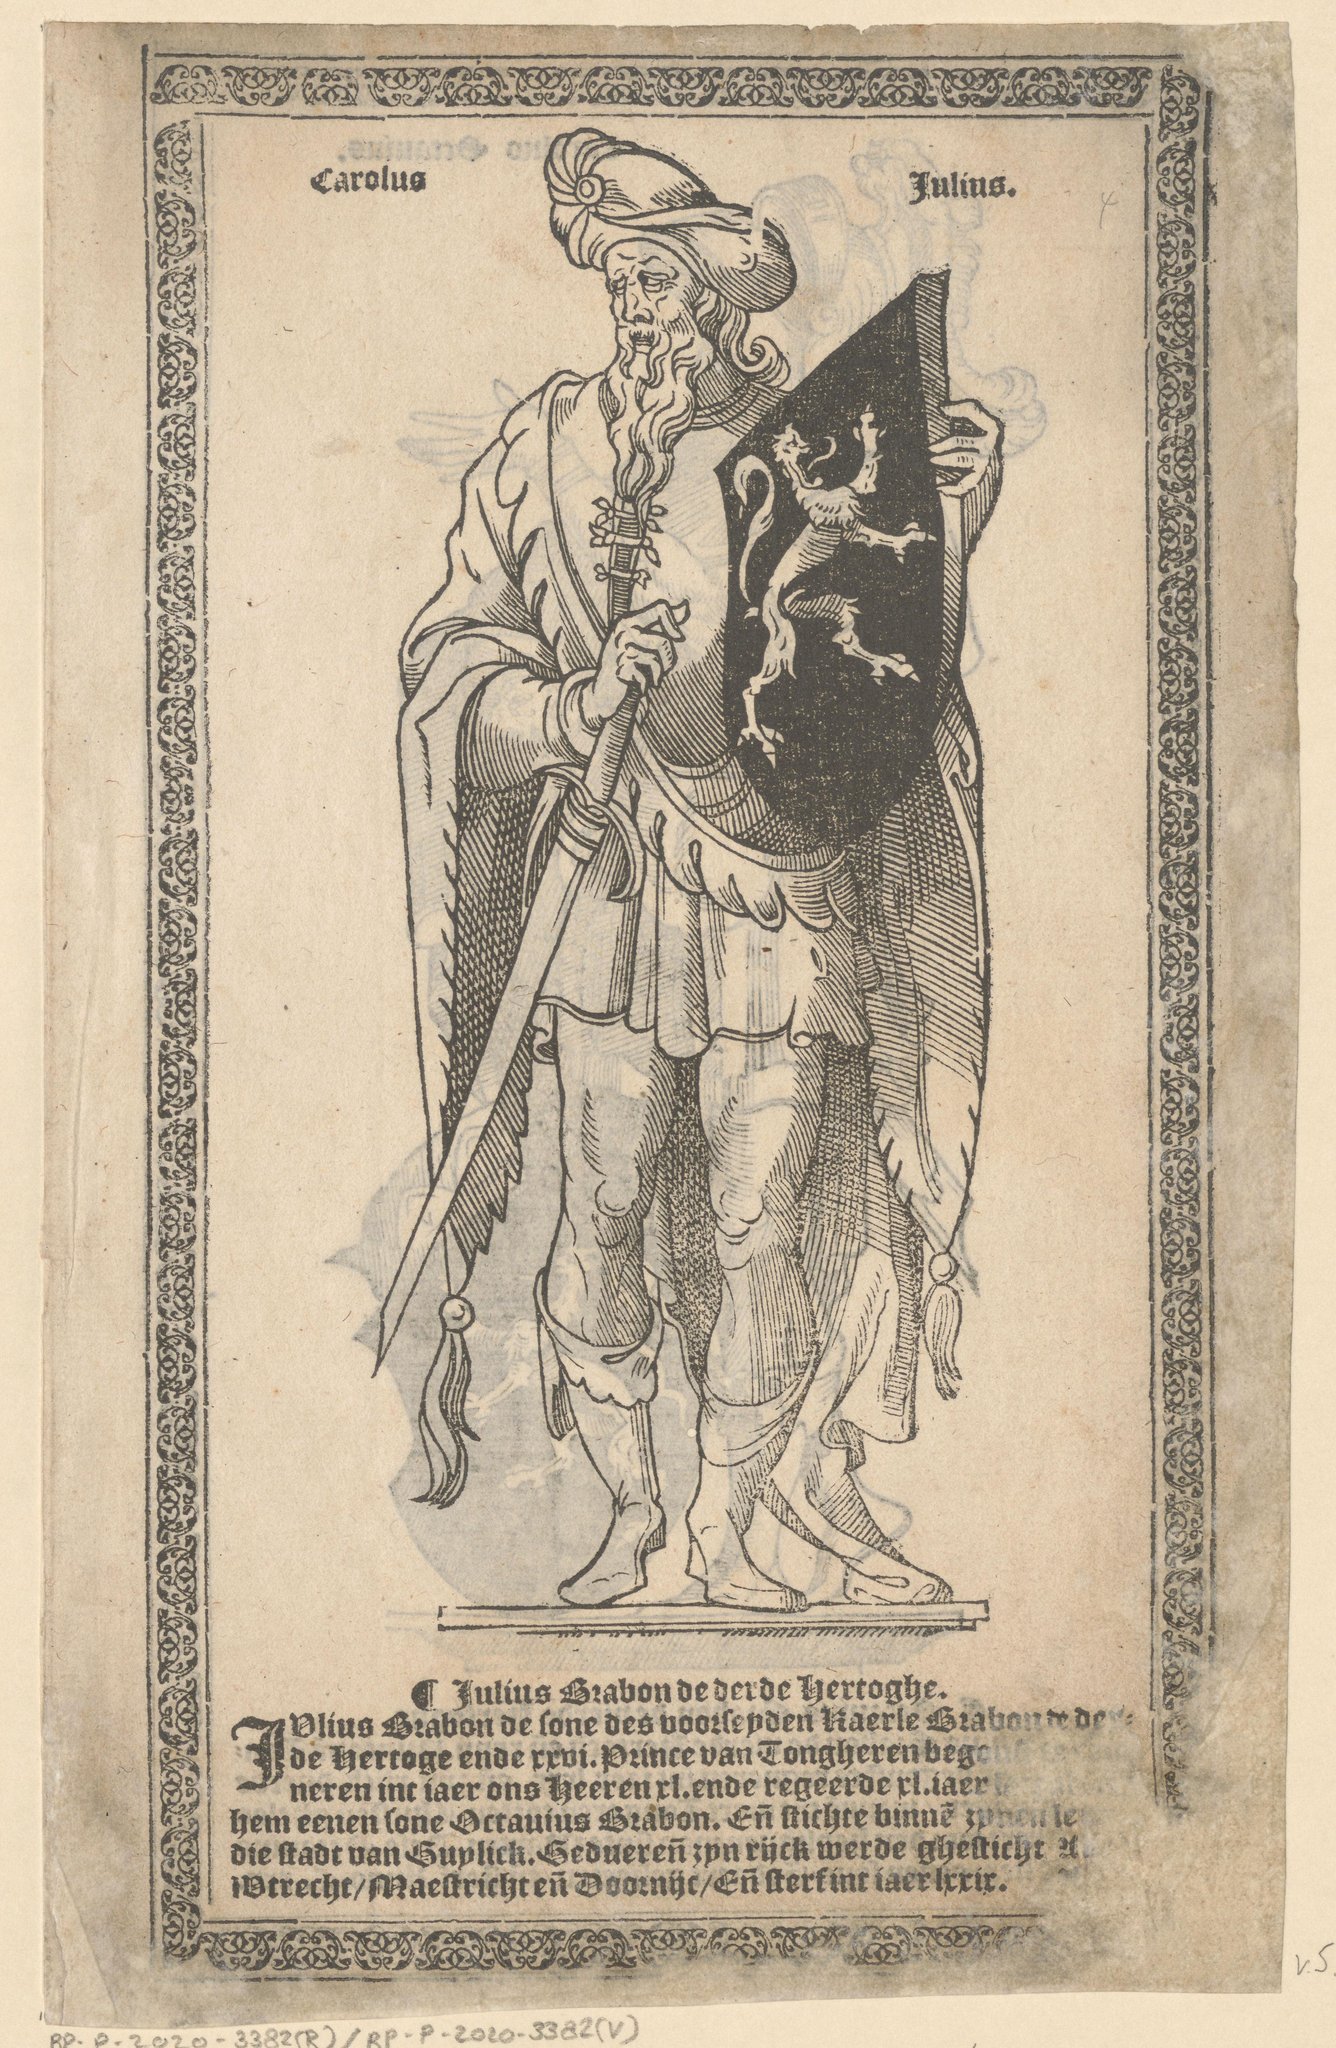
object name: print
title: Portret van Julius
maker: jan molijns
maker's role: print maker, publisher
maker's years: 1498-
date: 1565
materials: paper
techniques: letterpress printing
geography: antwerp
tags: hacking and thrusting weapons: sword, armorial bearing, heraldry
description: Prent uit: Dit is die afcoemste ende genalogie der hertoghen ende hertoginnen van Brabandt, (...). Antwerpen: Jan Molijns, 1565.